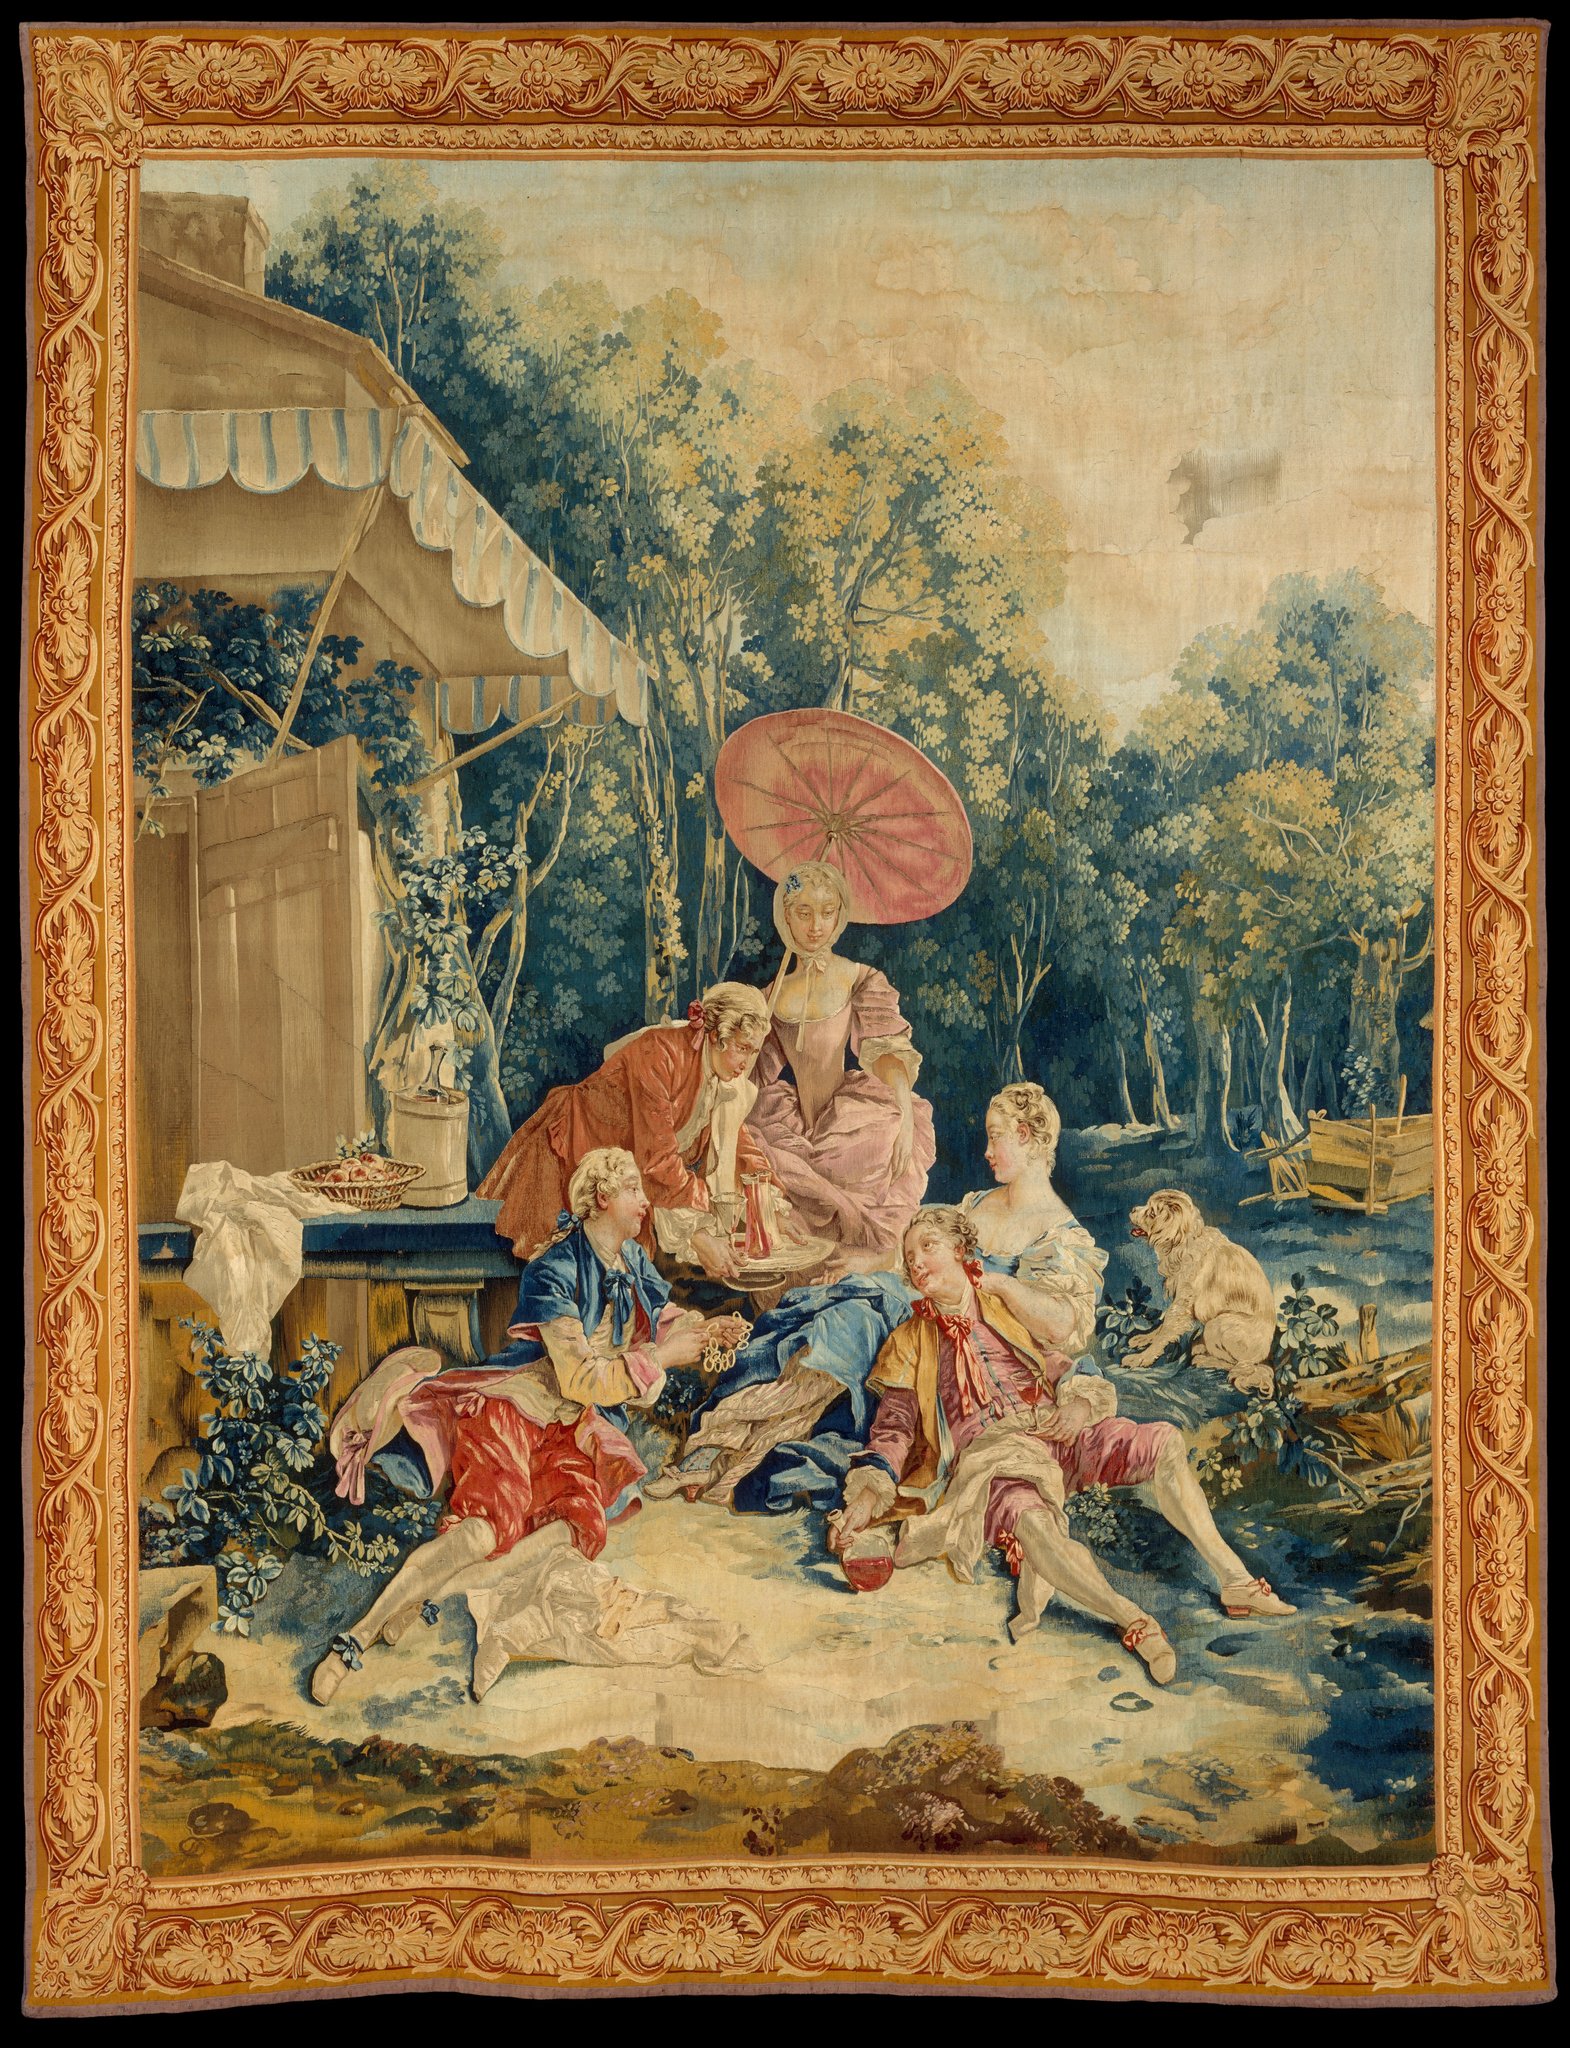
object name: tapestry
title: The Collation from a set of the Italian Village Scenes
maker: françois boucher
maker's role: artist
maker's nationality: french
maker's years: 1703-1770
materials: silk, wool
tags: couples,men,women,dogs,drinking